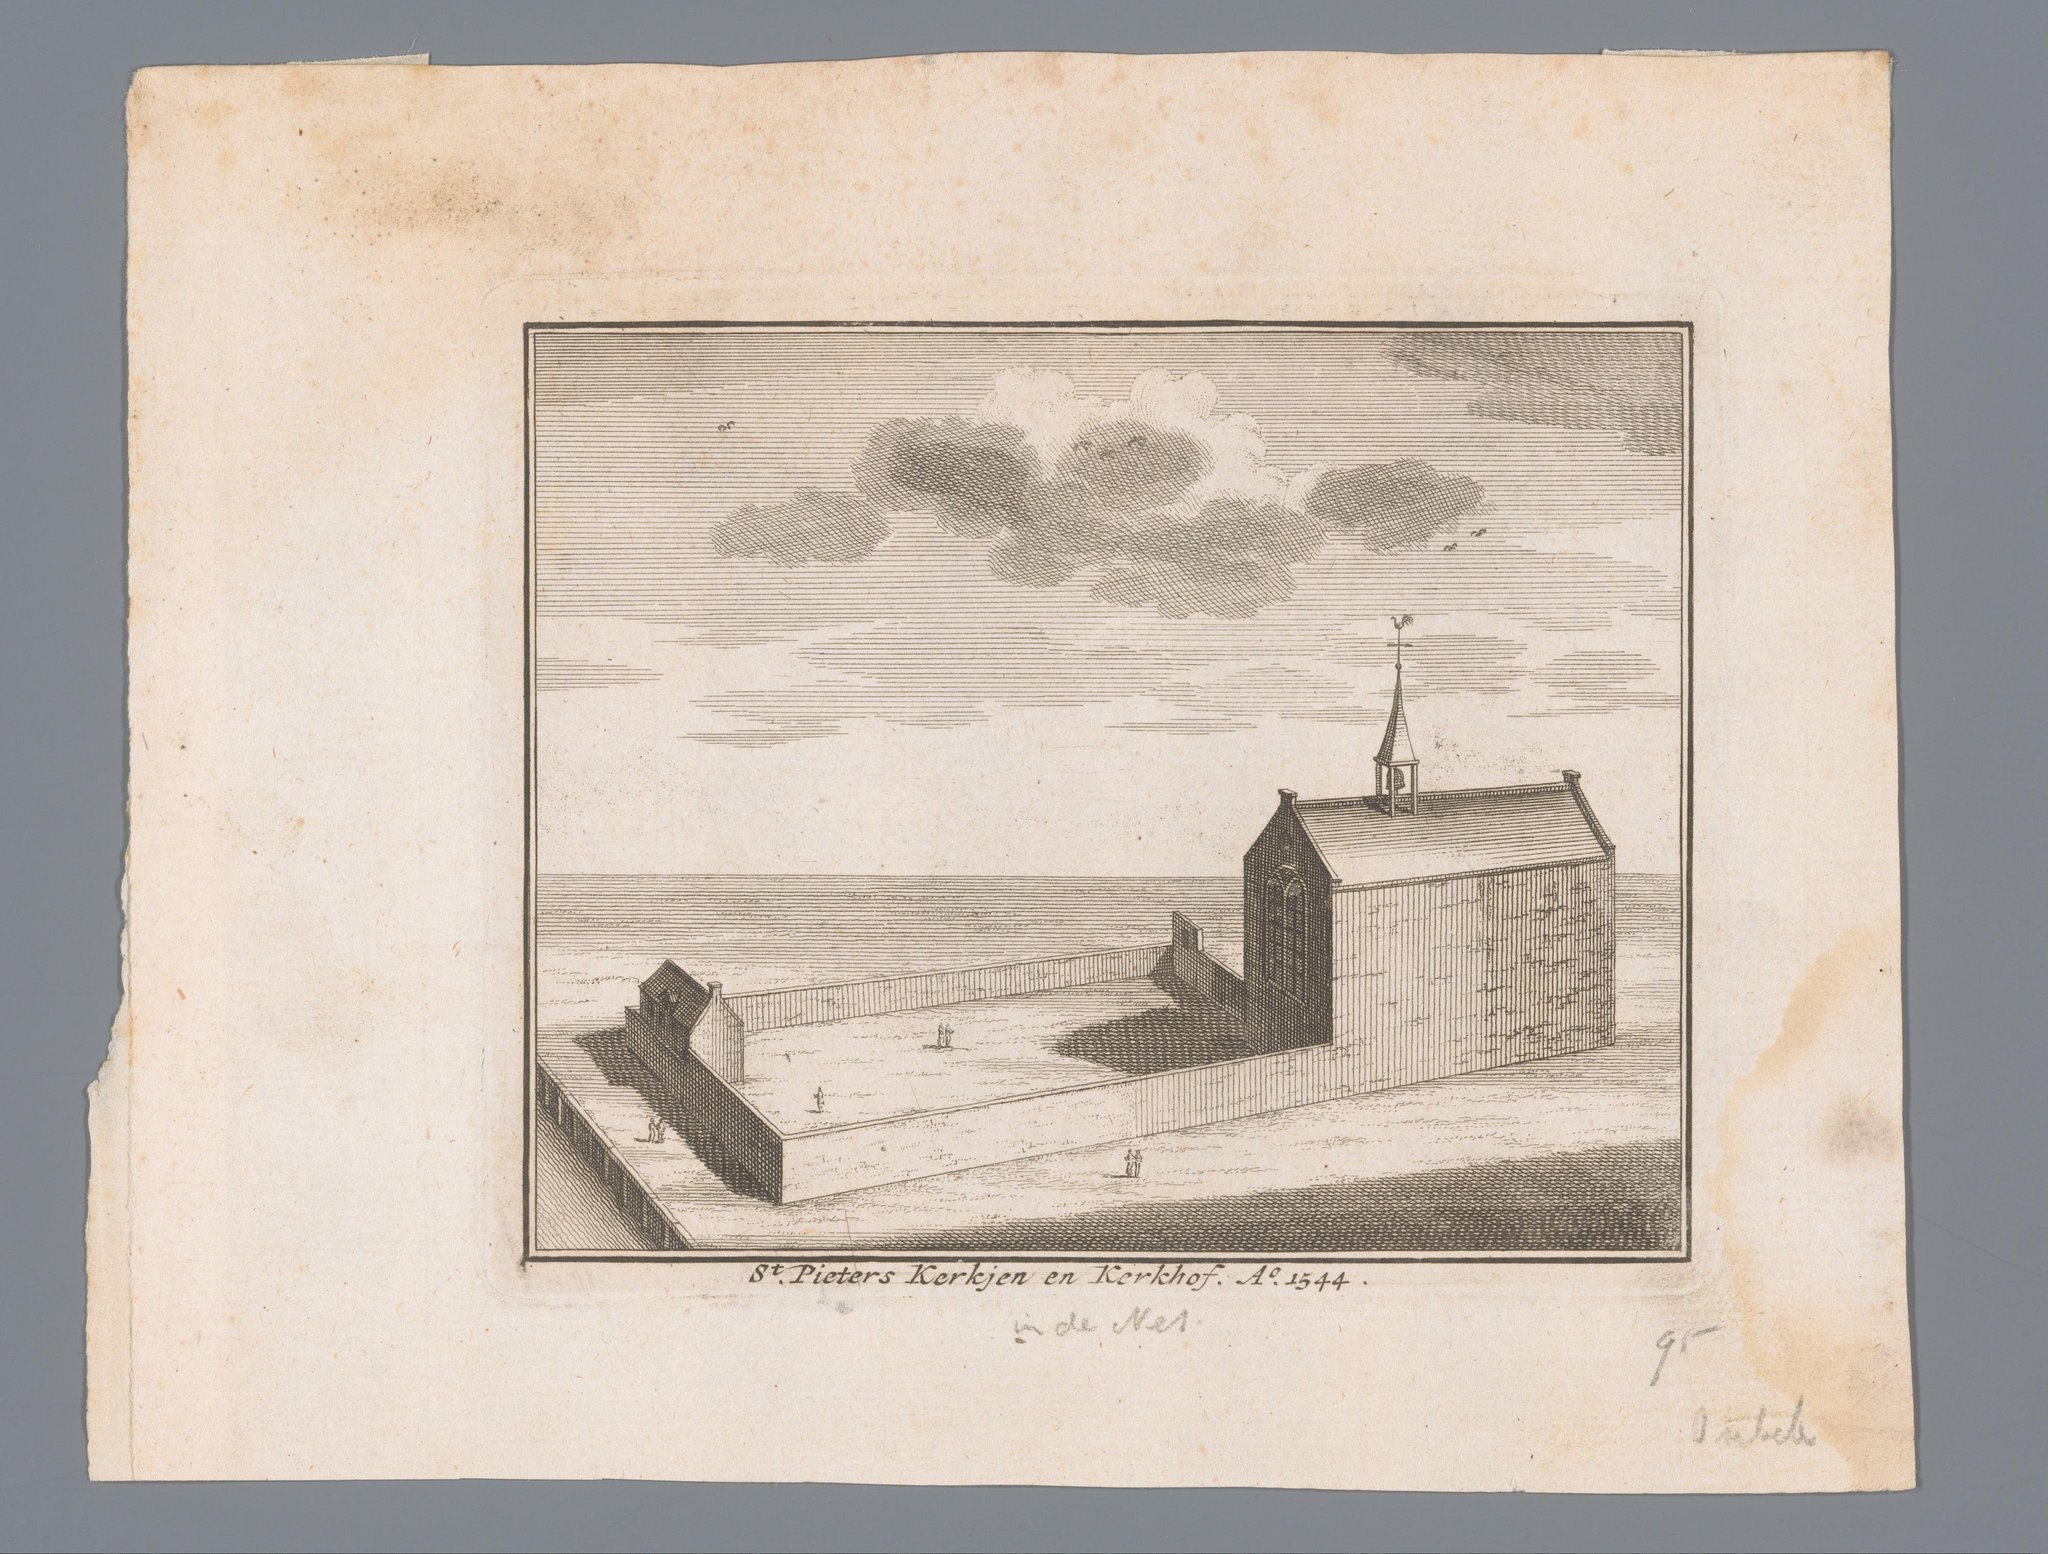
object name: print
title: Gezicht in vogelvlucht op de Sint-Pieterskapel te Amsterdam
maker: johannes van septeren (i)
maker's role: publisher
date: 1729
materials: paper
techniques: etching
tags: city-view, and landscape with man-made constructions